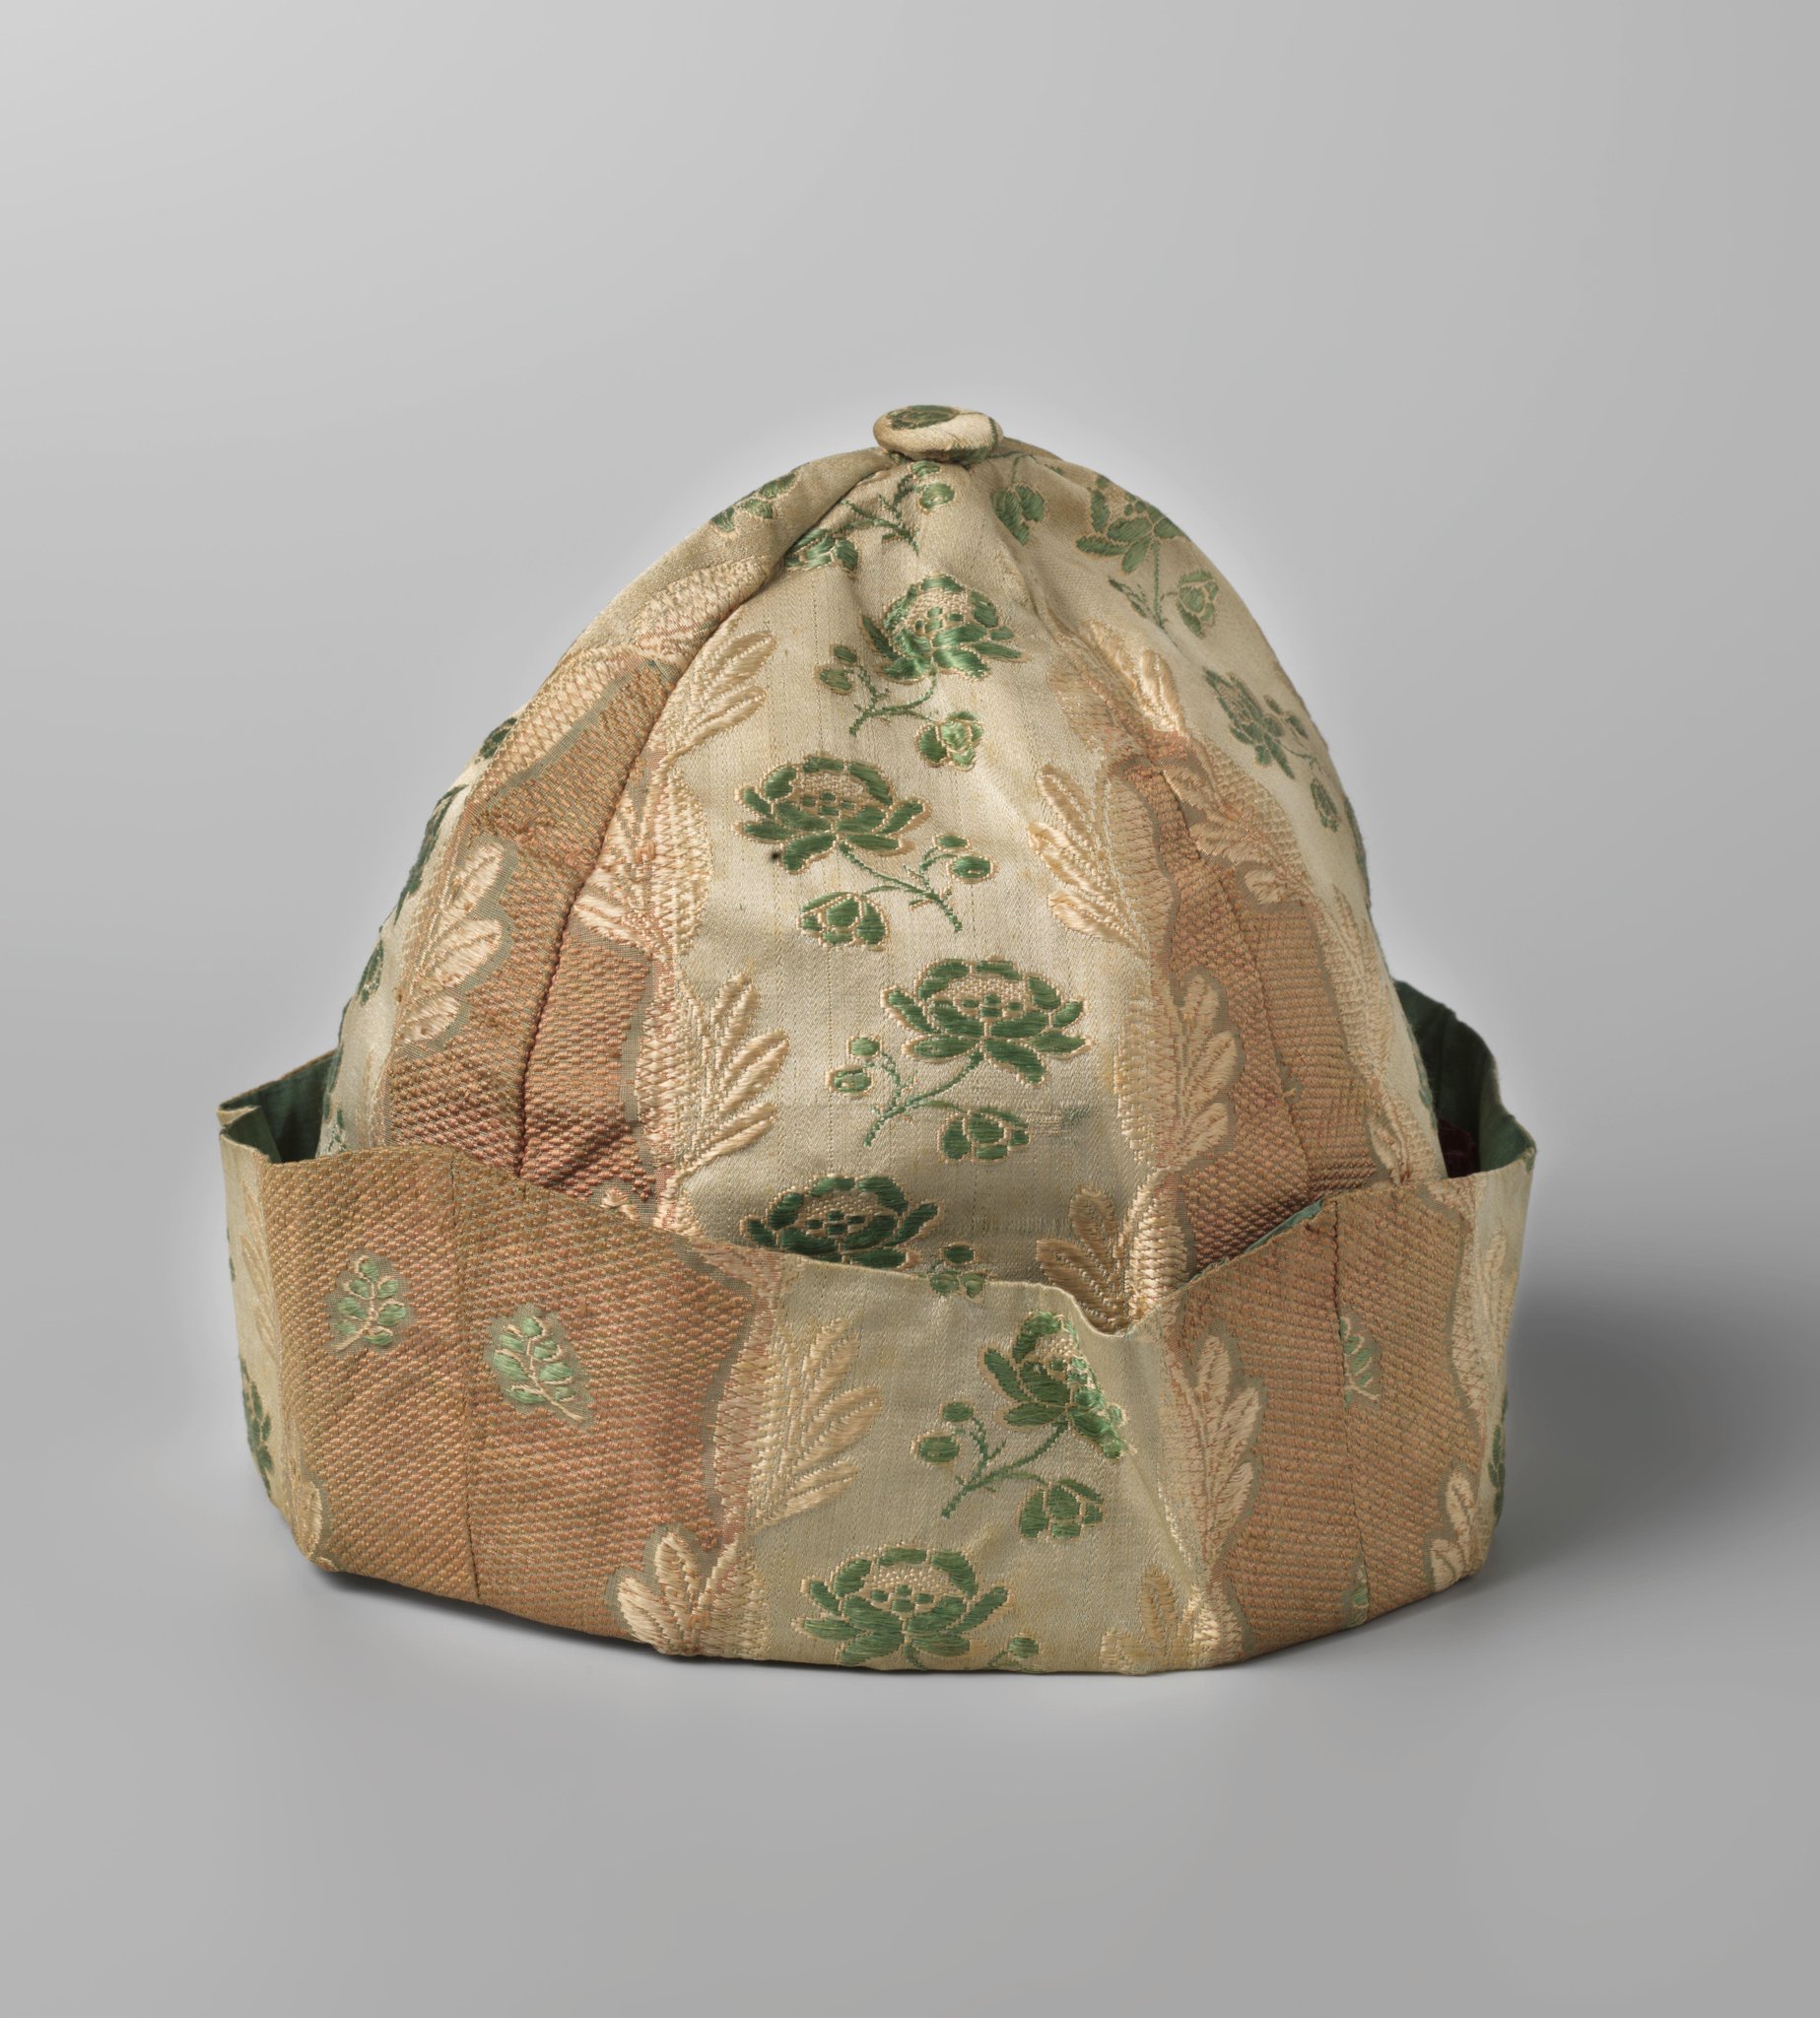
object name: huismuts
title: Muts van gestreepte roze zijde gebrocheerd met groene rozen, bestaande uit vier pattes met ieder een aangezette rand die is teruggeslagen, midden op de bol een met stof beklede knoop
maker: Anonymous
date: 1700-1770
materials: silk, wood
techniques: brocade, cutting, upholstery, weave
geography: netherlands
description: Muts, kraamherenmuts of bruidegomsmuts, van gestreepte roze zijde gebrocheerd met groene rozen. Model: vier pattes met ieder een aangezette rand die is teruggeslagen. Midden op de bol een met stof beklede knoop. De rand is gevoerd met flessengroene zijde. Op de overgang van de voering naar de rand een 1,5 cm brede tunnel waar een paars lint door getrokken is. Middenachter twee gefestonneerde gaten waardoor het lint aan de buitenkant gestrikt kan worden. De tunnel en het bovenste deel van de rand zijn verstevigd.